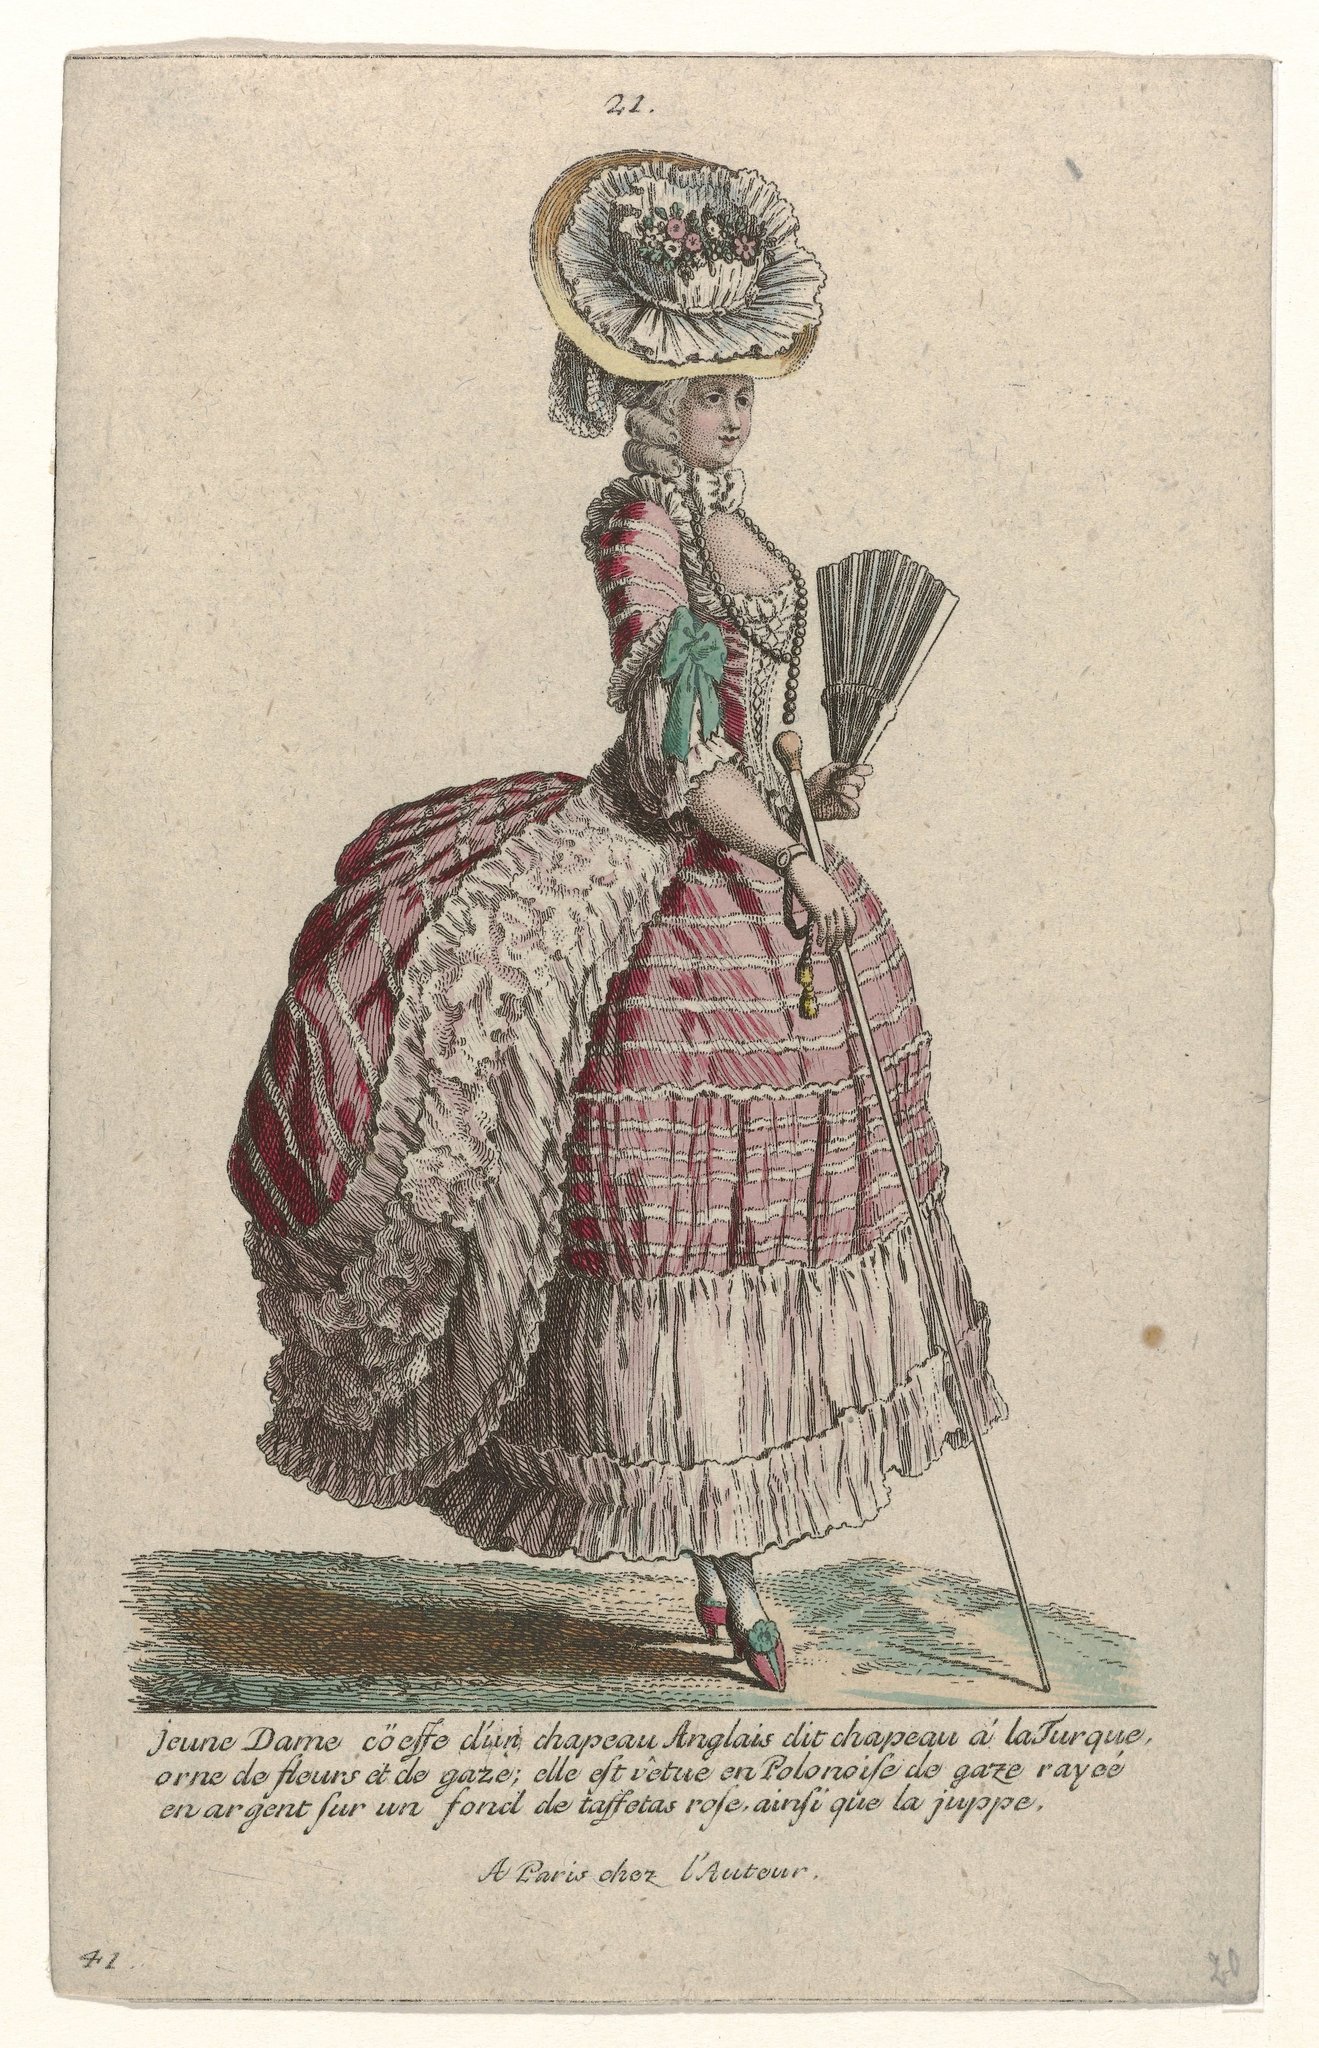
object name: fashion print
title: Gallerie des Modes et Costumes Français, 1785, nr. 21, nr. 41, Kopie naar V 123 : Jeune dame coëffé d'un chapeau Anglais (...)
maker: pierre gleich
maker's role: print maker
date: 1785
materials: paper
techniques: engraving, hand coloring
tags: walking-stick, staff, cane (+ women's clothes), fashion plates, head-gear: hat (+ women's clothes), shoes, sandals (+ women's clothes), skirt (+ women's clothes), neck-gear ~ clothing (+ women's clothes), dress, gown: robe à la polonaise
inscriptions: caption: ‘A Paris chez l'Auteur’, caption: ‘Jeune dame coëffé d'un chapeau Anglais dit chapeau á la Turque, orne de fleurs et de gaze; elle est vêtue en Polonoise de gaze rayée en argent sur un fond de taffetas rose, ainsi que la juppe.’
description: Jonge vrouw, lopend naar rechts, gekleed in een 'robe à la Polonaise' met manches en sabot versierd met strikken. De japon en rok zijn gemaakt van zilverkleurig getreepte tule op een ondergrond van roze tafzijde. Op het hoofd een hoed 'Anglais' of 'à la Turque' versierd met tule en bloemen. Accessoires: gestrikte halsdoek, collier, vouwwaaier, armband, wandelstok met gouden knop, lint en kwastjes, schoenen met hakken, strepen en bloemen(?). Kopie naar V 123 uit serie V. 21e Cahier des Costumes Français, 15e Suite d'Habillemens à la mode en 1779, Gallerie des Modes et Costumes Français.